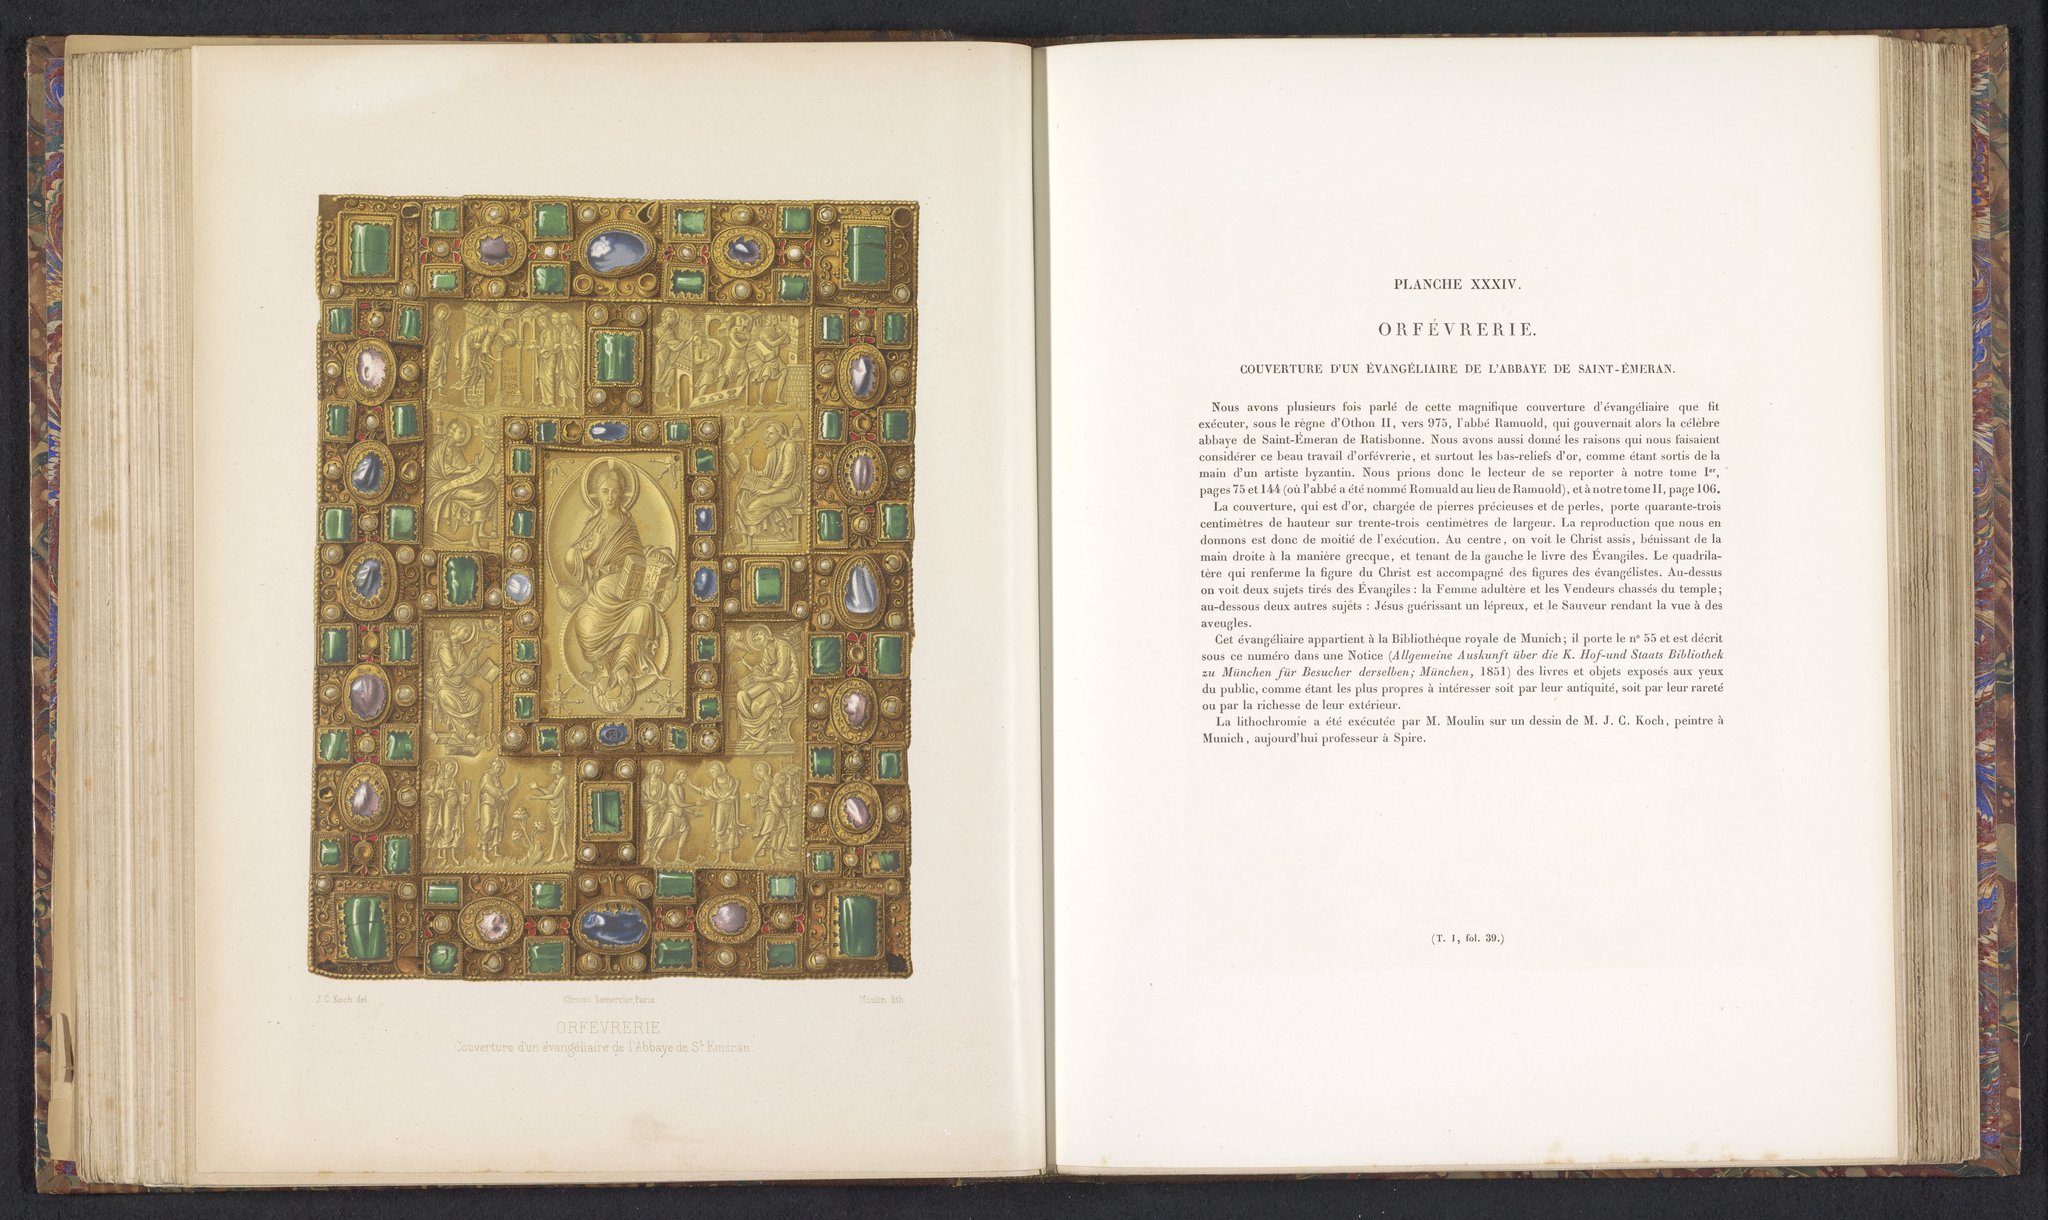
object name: page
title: Kaft van een evangeliarium, afkomstig uit de Abdij van Sankt Emmeram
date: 1859-1864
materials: paper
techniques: chromolithography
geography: paris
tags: book-cover, binding